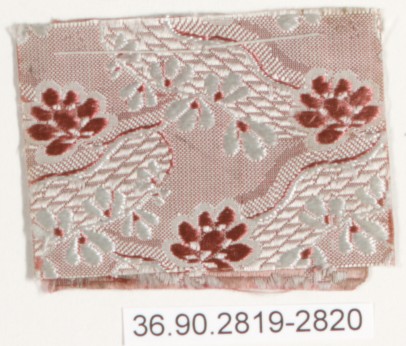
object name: piece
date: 1801-1900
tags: flowers